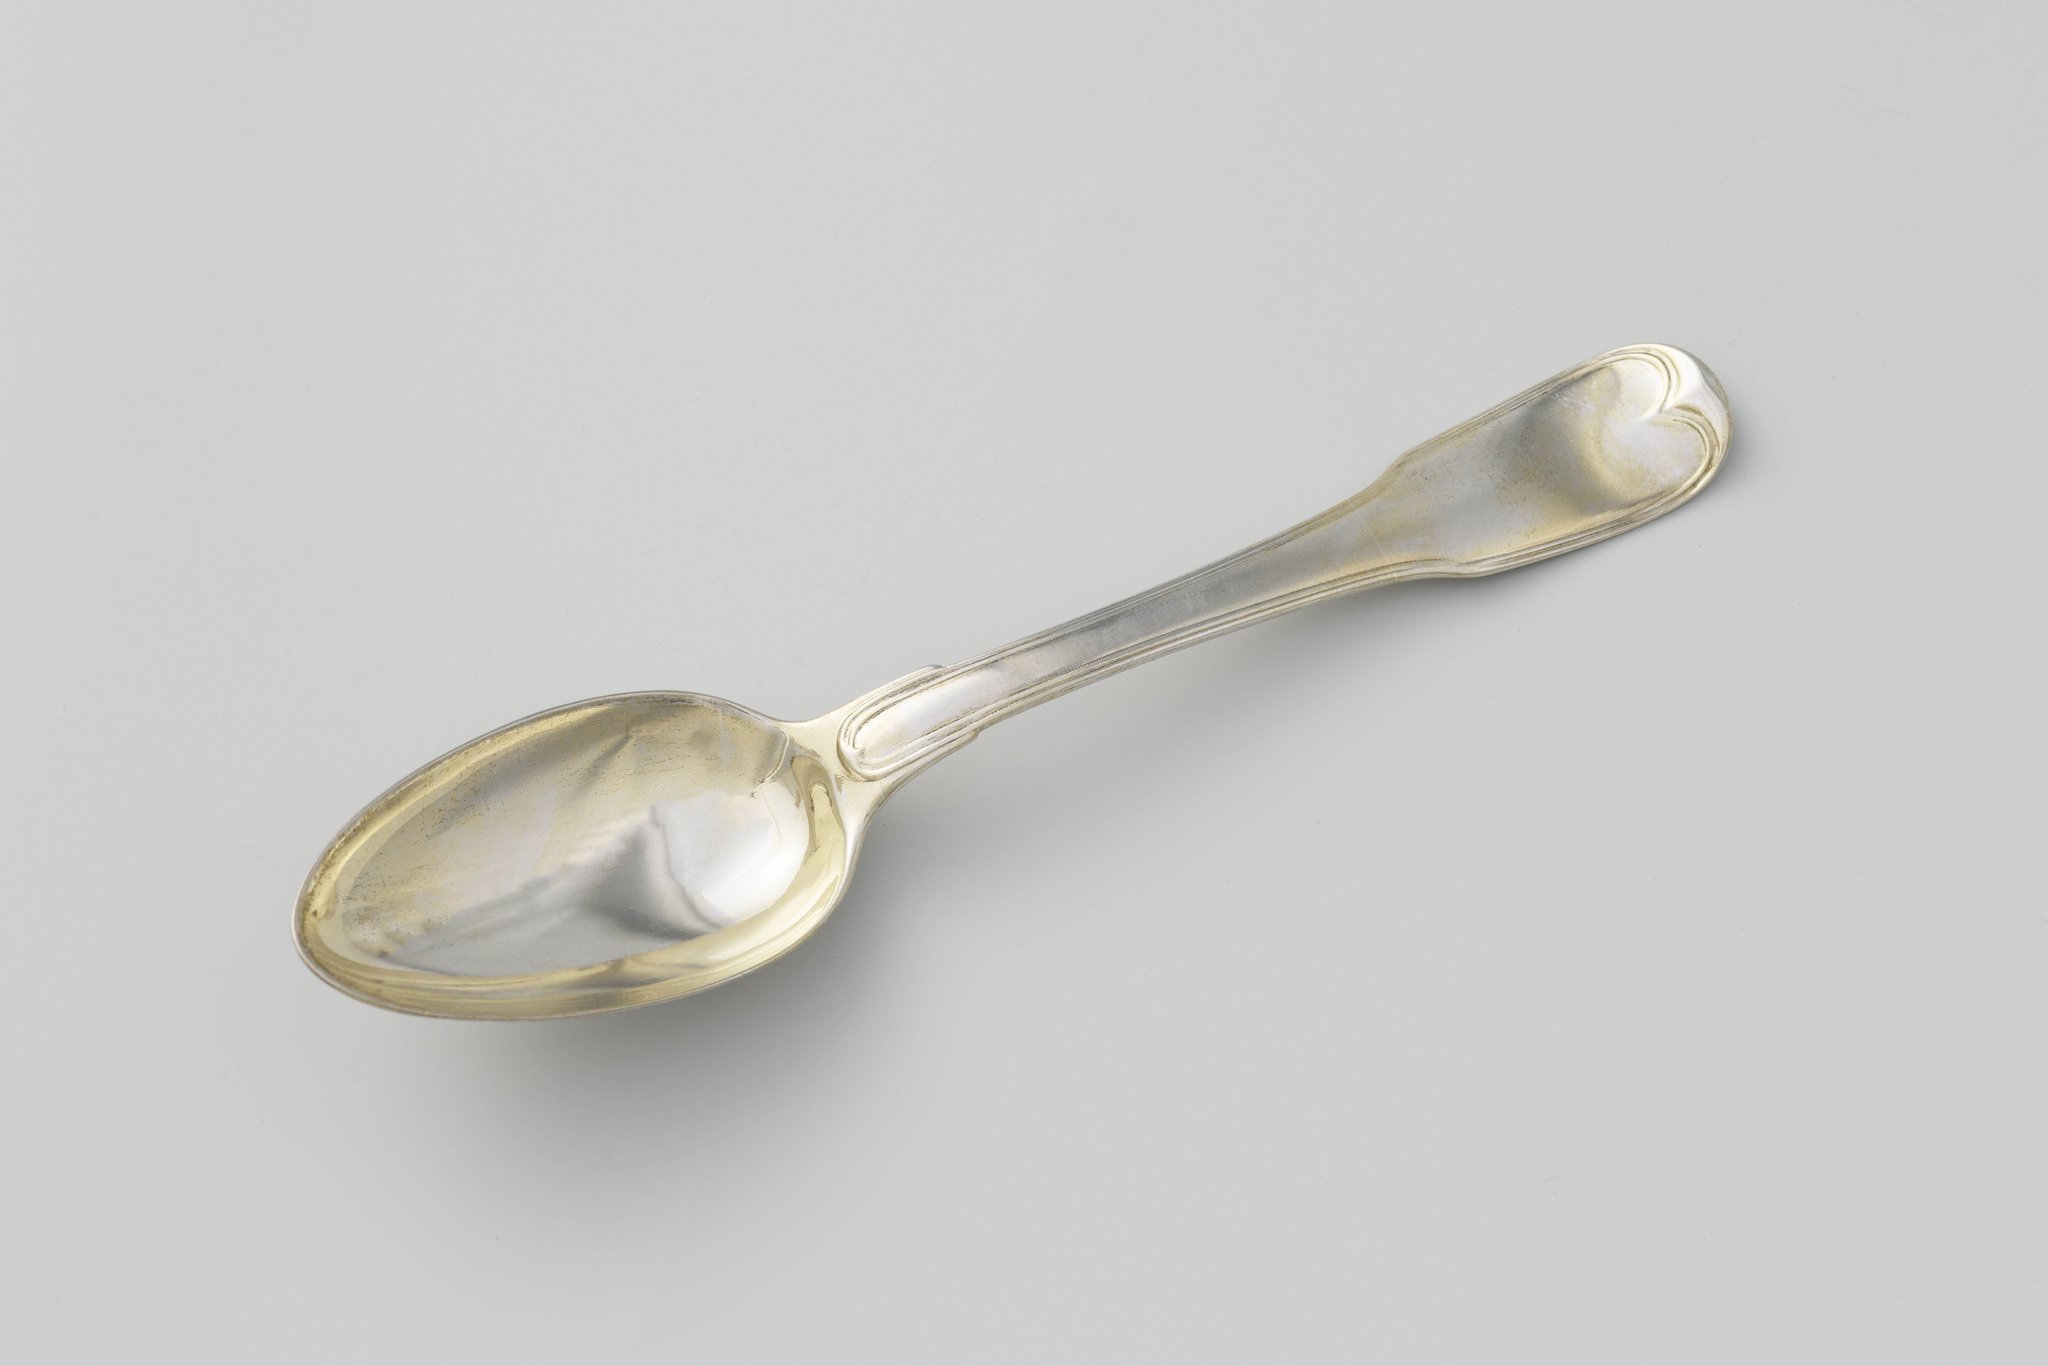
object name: spoon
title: Lepel met het helmteken Clifford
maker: roelof helweg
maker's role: silversmith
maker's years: 1758-1843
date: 1806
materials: silver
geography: amsterdam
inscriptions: alloy mark: ‘Hollandse leeuw’, town mark: ‘Amsterdam’, maker's mark: ‘RH in ovaal’, date letter: ‘X (=1806)’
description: De eivormige bak van de lepel is aan zowel boven- als onderzijde door middel van enkel lof verbonden met de platte, gebogen steel, die zich verbreedt naar het spatelvormige uiteinde. Boven- en onderzijde van de steel worden omgeven door een dubbele filetrand, die bij het uiteinde ingezwenkt is. Op de onderzijde van de spatel is het helmteken Clifford gegraveerd.